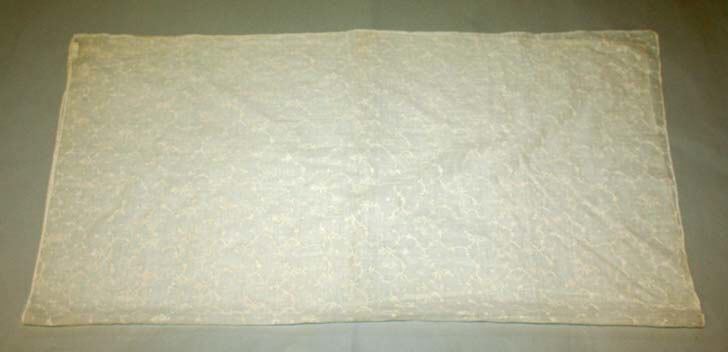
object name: fichu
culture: american or european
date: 1801-1833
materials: cotton